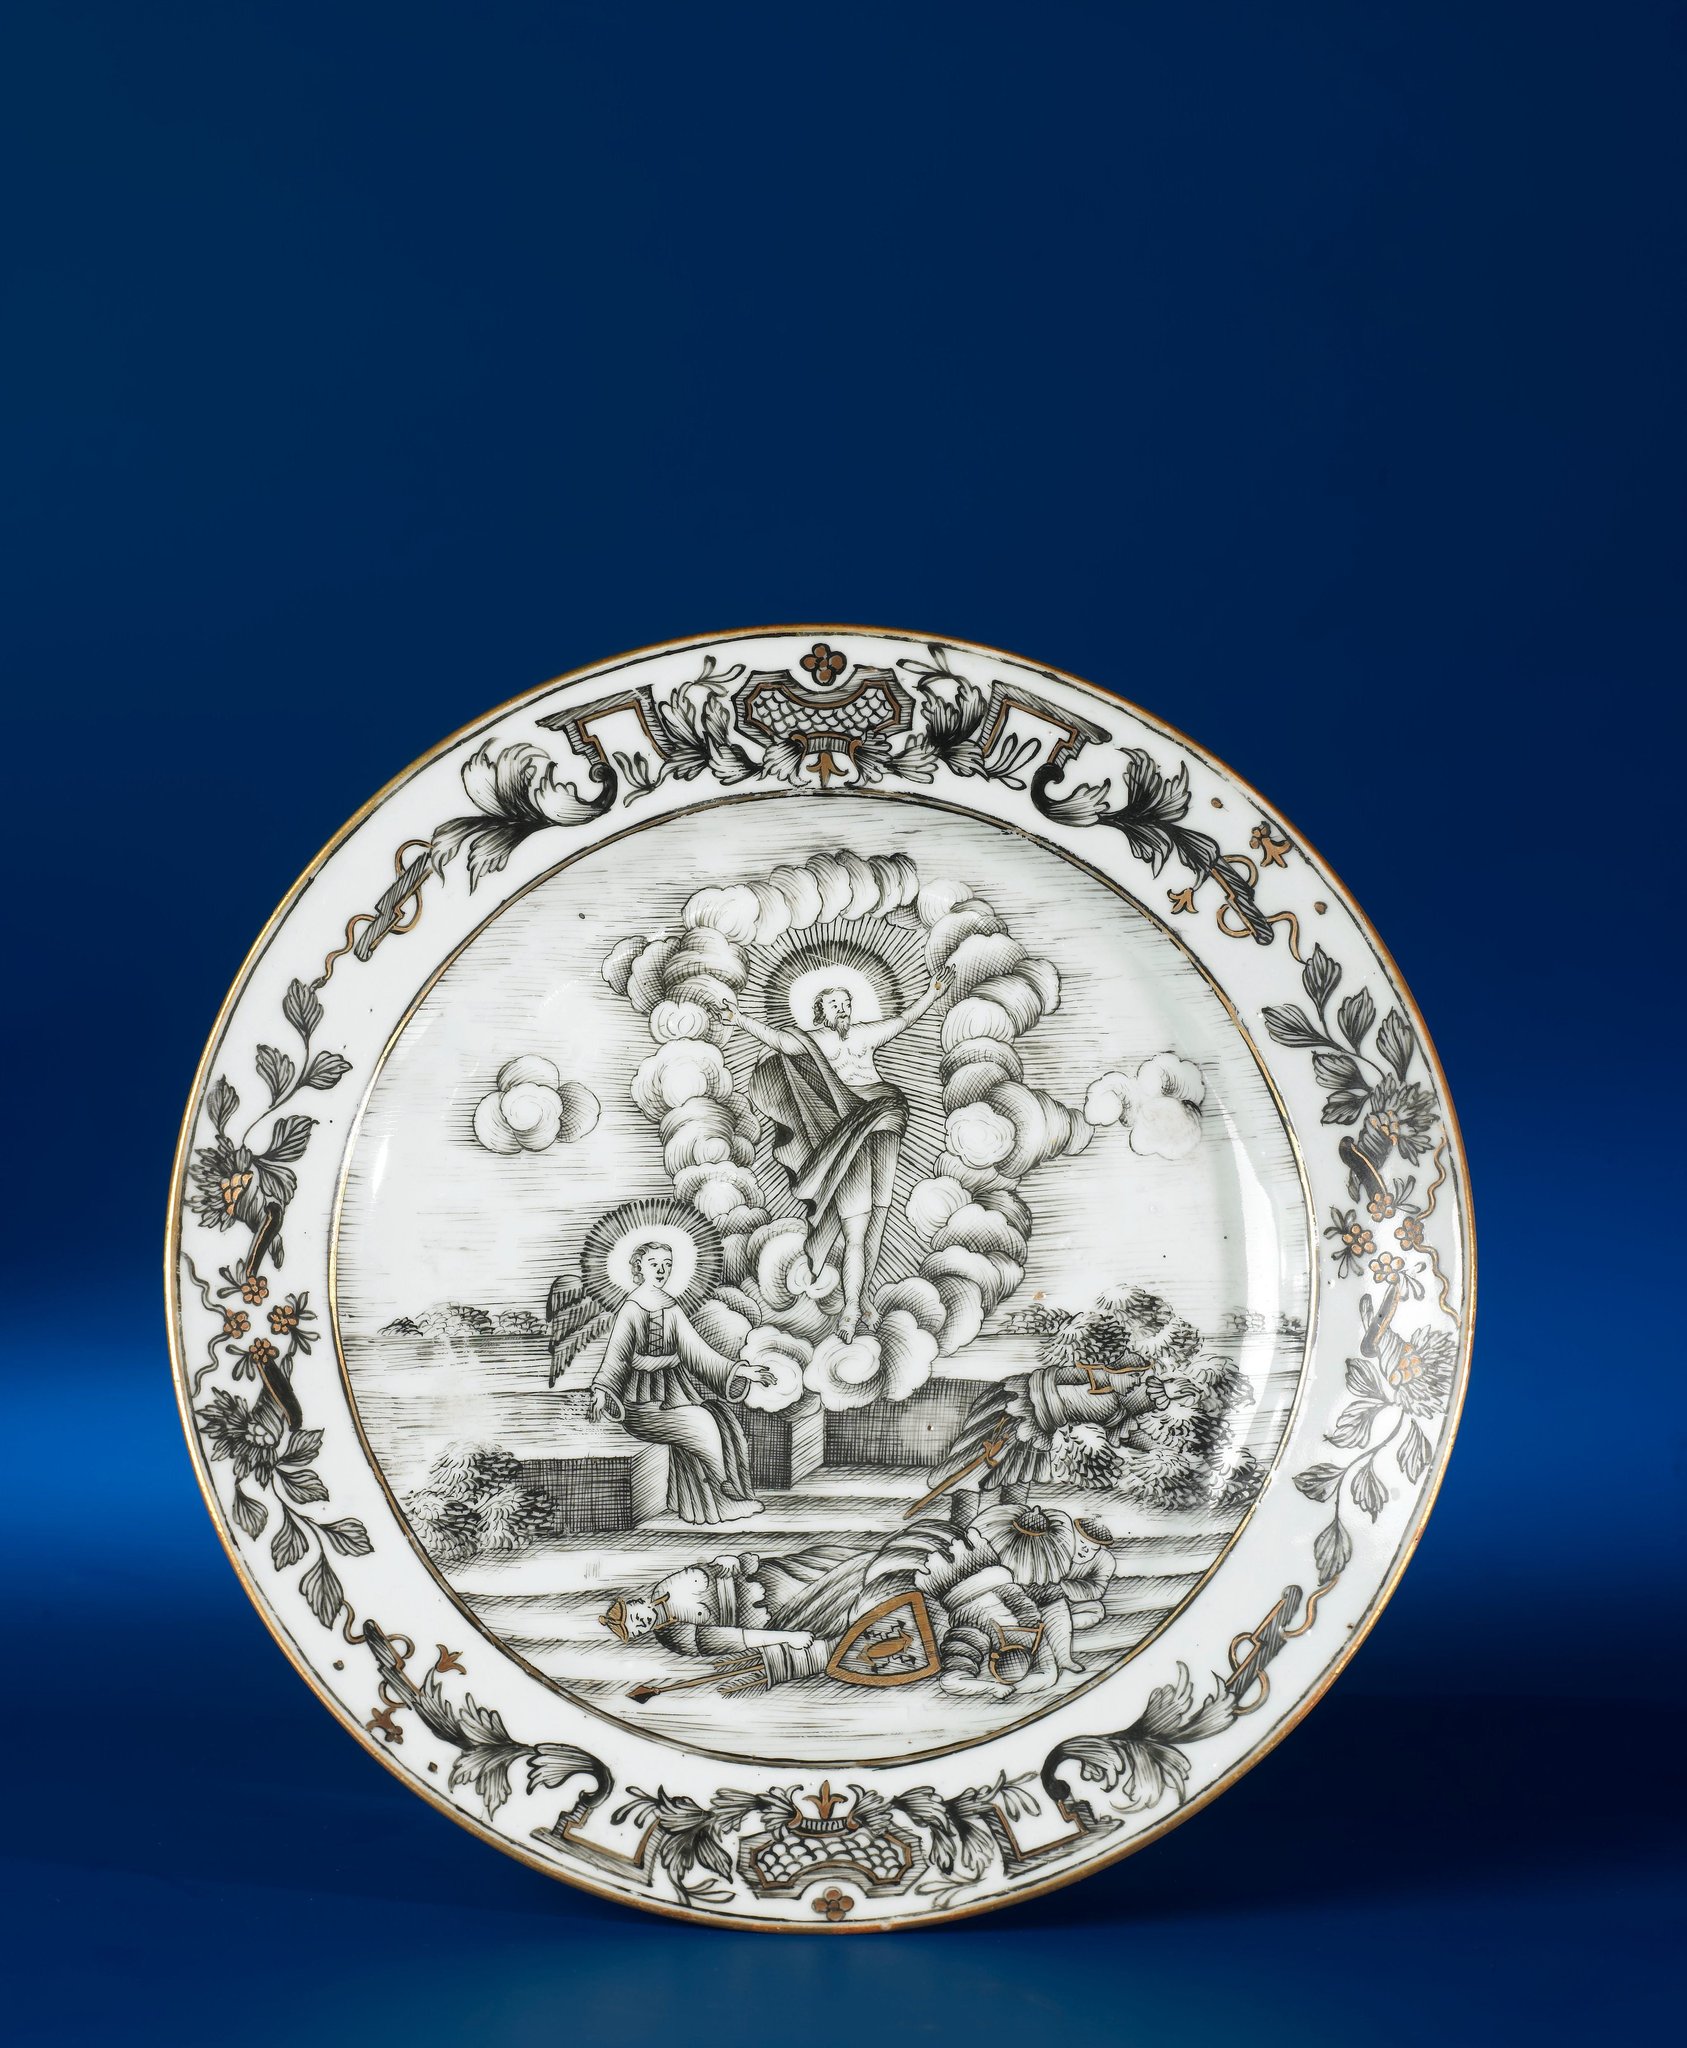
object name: plate dish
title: Plate with an image of the Ressurection of Christ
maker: Anonymous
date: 1740-1760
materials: glaze, gold, paint, porcelain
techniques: firing, gilding, turning, vitrification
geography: china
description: Bord op een voetring, met een platte rand. Gedecoreerd in encre de Chine met een voorstelling van de Opstanding van Christus. De rand is gedecoreerd met een Laub- und Bandelwerk band, in de stijl van het Weense Du Paquier porselein. Deze rand bestaat uit zich kruisende lijnen, met ertussen een figuurtje. De lijnen lopen uit in een bladachtig motief. Tussen 1745 en 1750 waren religieuze scènes zeer populair. Naast de Opstanding werden ook de Kruisiging, de Geboorte en de Hemelvaart veelvuldig op porselein aangebracht, zowel polychroom als in encre de Chine. Tenminste acht varianten van de randen zijn bekend. De polychrome exemplaren bij deze borden zijn zeldzamer dan de exemplaren in encre de Chine. Naast borden zijn er ook onderdelen van thee-, koffie- en chocoladeserviezen met deze vier voorstellingen bekend. Kommen, soepborden of schalen en andere serviesonderdelen ontbreken. Aangenomen kan worden dat de borden voornamelijk een decoratieve functie hadden. De Opstanding van Christus was een terugkeer op aarde, hij verrees op de derde dag na zijn dood. Hij bleef nog veertig dagen op de aarde vóór de Hemelvaart. Links naast Christus zit een engel op zijn graf. Op het encre de Chine zijn op de achtergrond drie figuurtjes te zien. In het bijbelverhaal zijn het drie vrouwen die door de engel worden aangesproken, waarschijnlijk werd dit niet begrepen door de Chinese schilder. Op de voorgrond enkele soldaten die het graf bewaken. De scènes in deze serie zijn nauwgezette kopieën van prenten die de Amsterdamse dichter en graveur Jan Luyken (1649-1712) maakte voor verschillende edities van de Lutherse Nederduytse Bijbel.